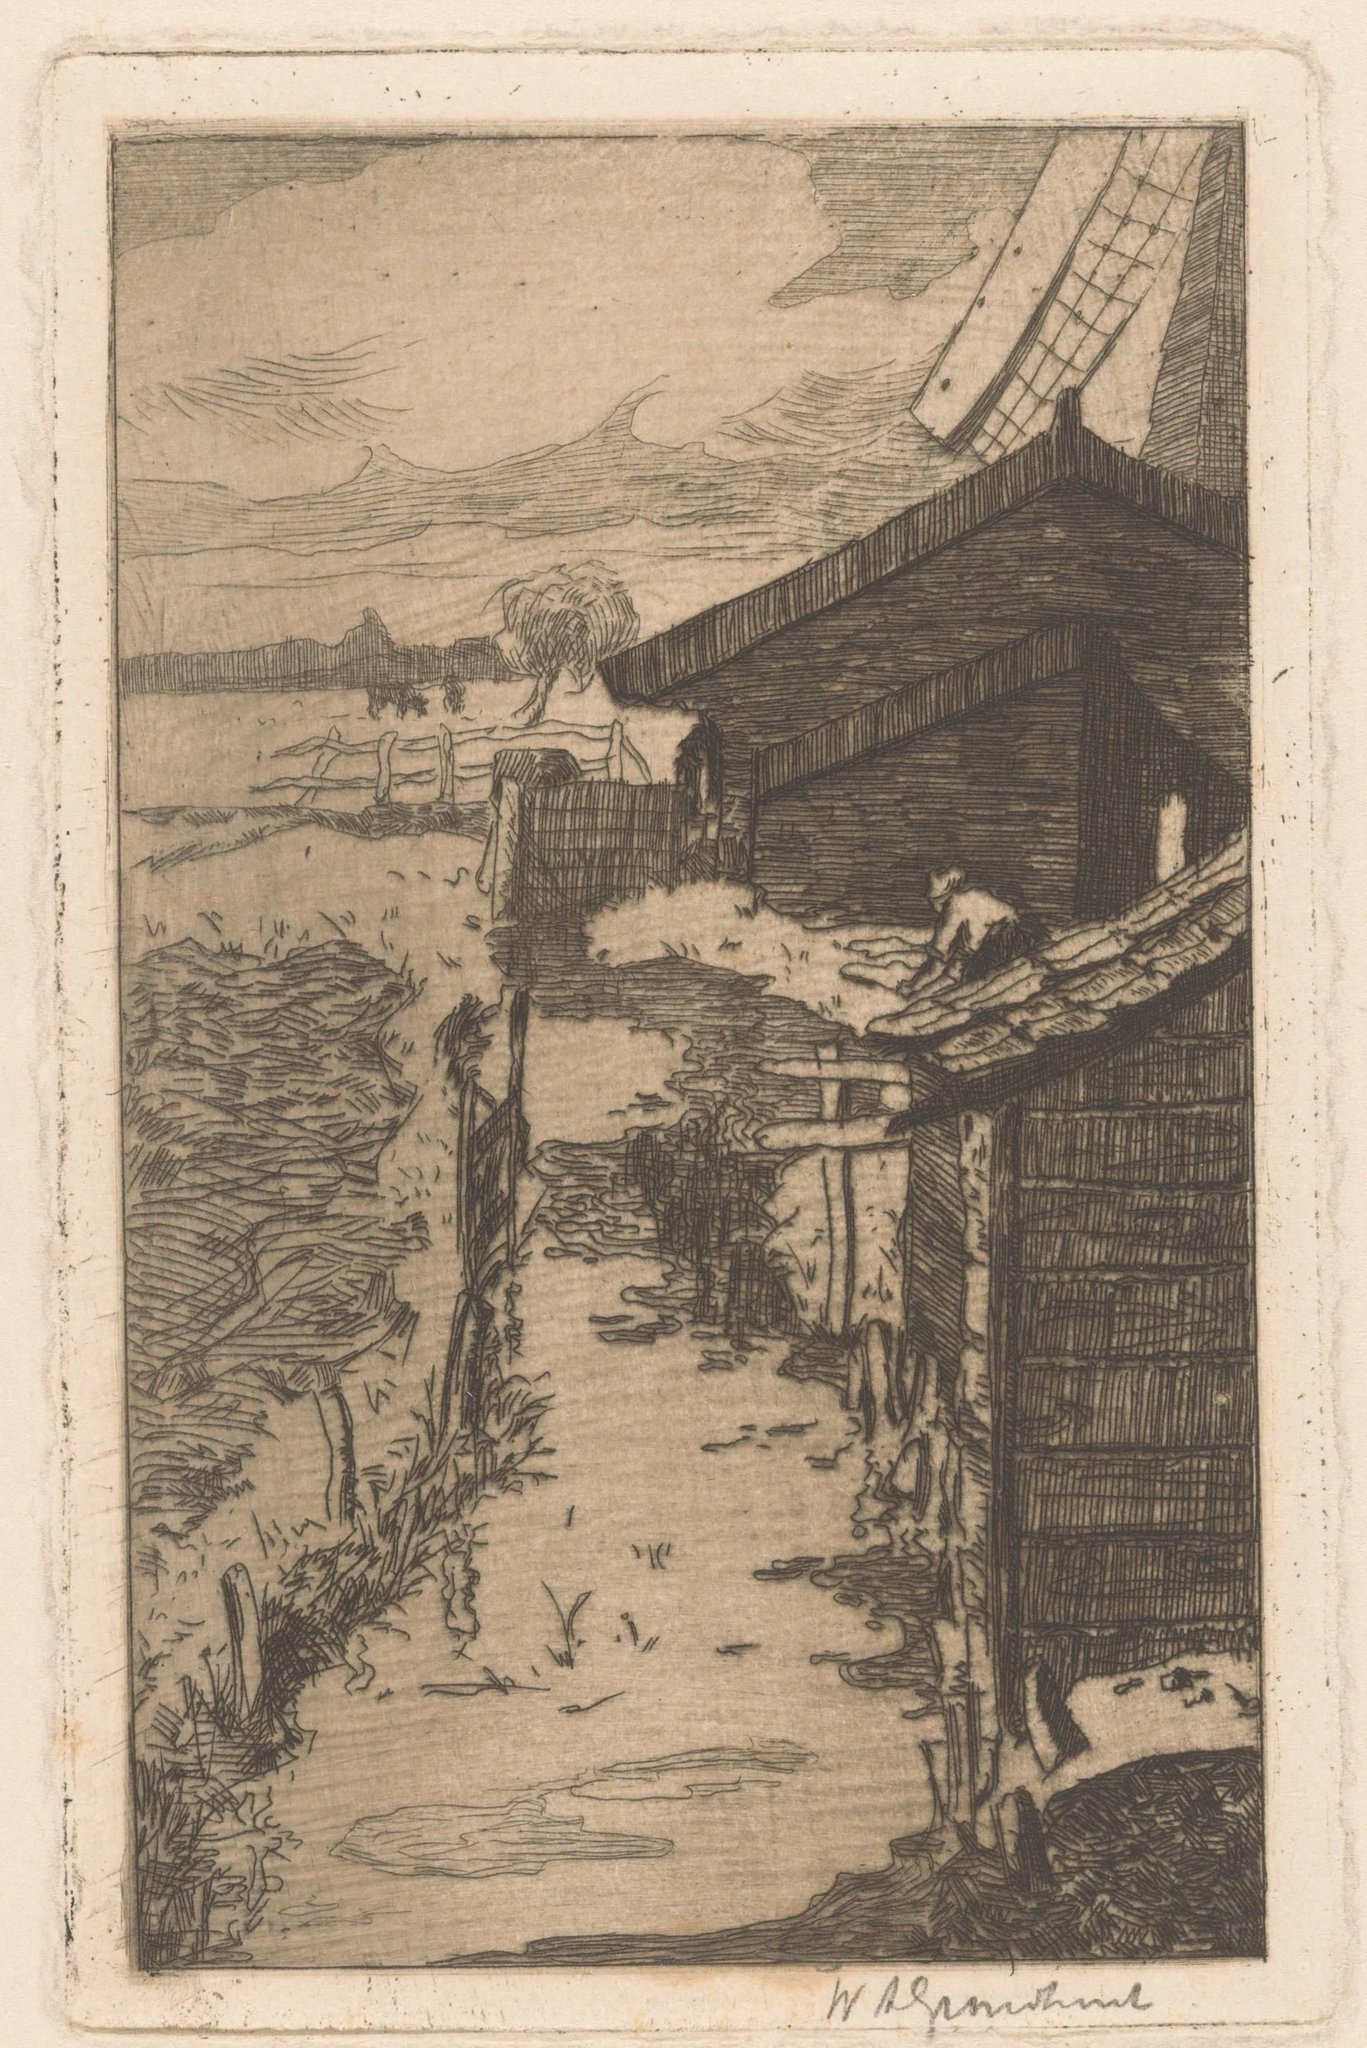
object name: print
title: Landschap met sloot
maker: willem adrianus grondhout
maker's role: draughtsman, painter, print maker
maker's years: 1878-1934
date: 1888-1934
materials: paper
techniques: etching, intaglio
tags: small canal, ditch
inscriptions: collector's mark: Lugt 2228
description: Rechts meerdere gebouwen, waaronder een molen. Op de achtergrond grazend vee in een weiland.